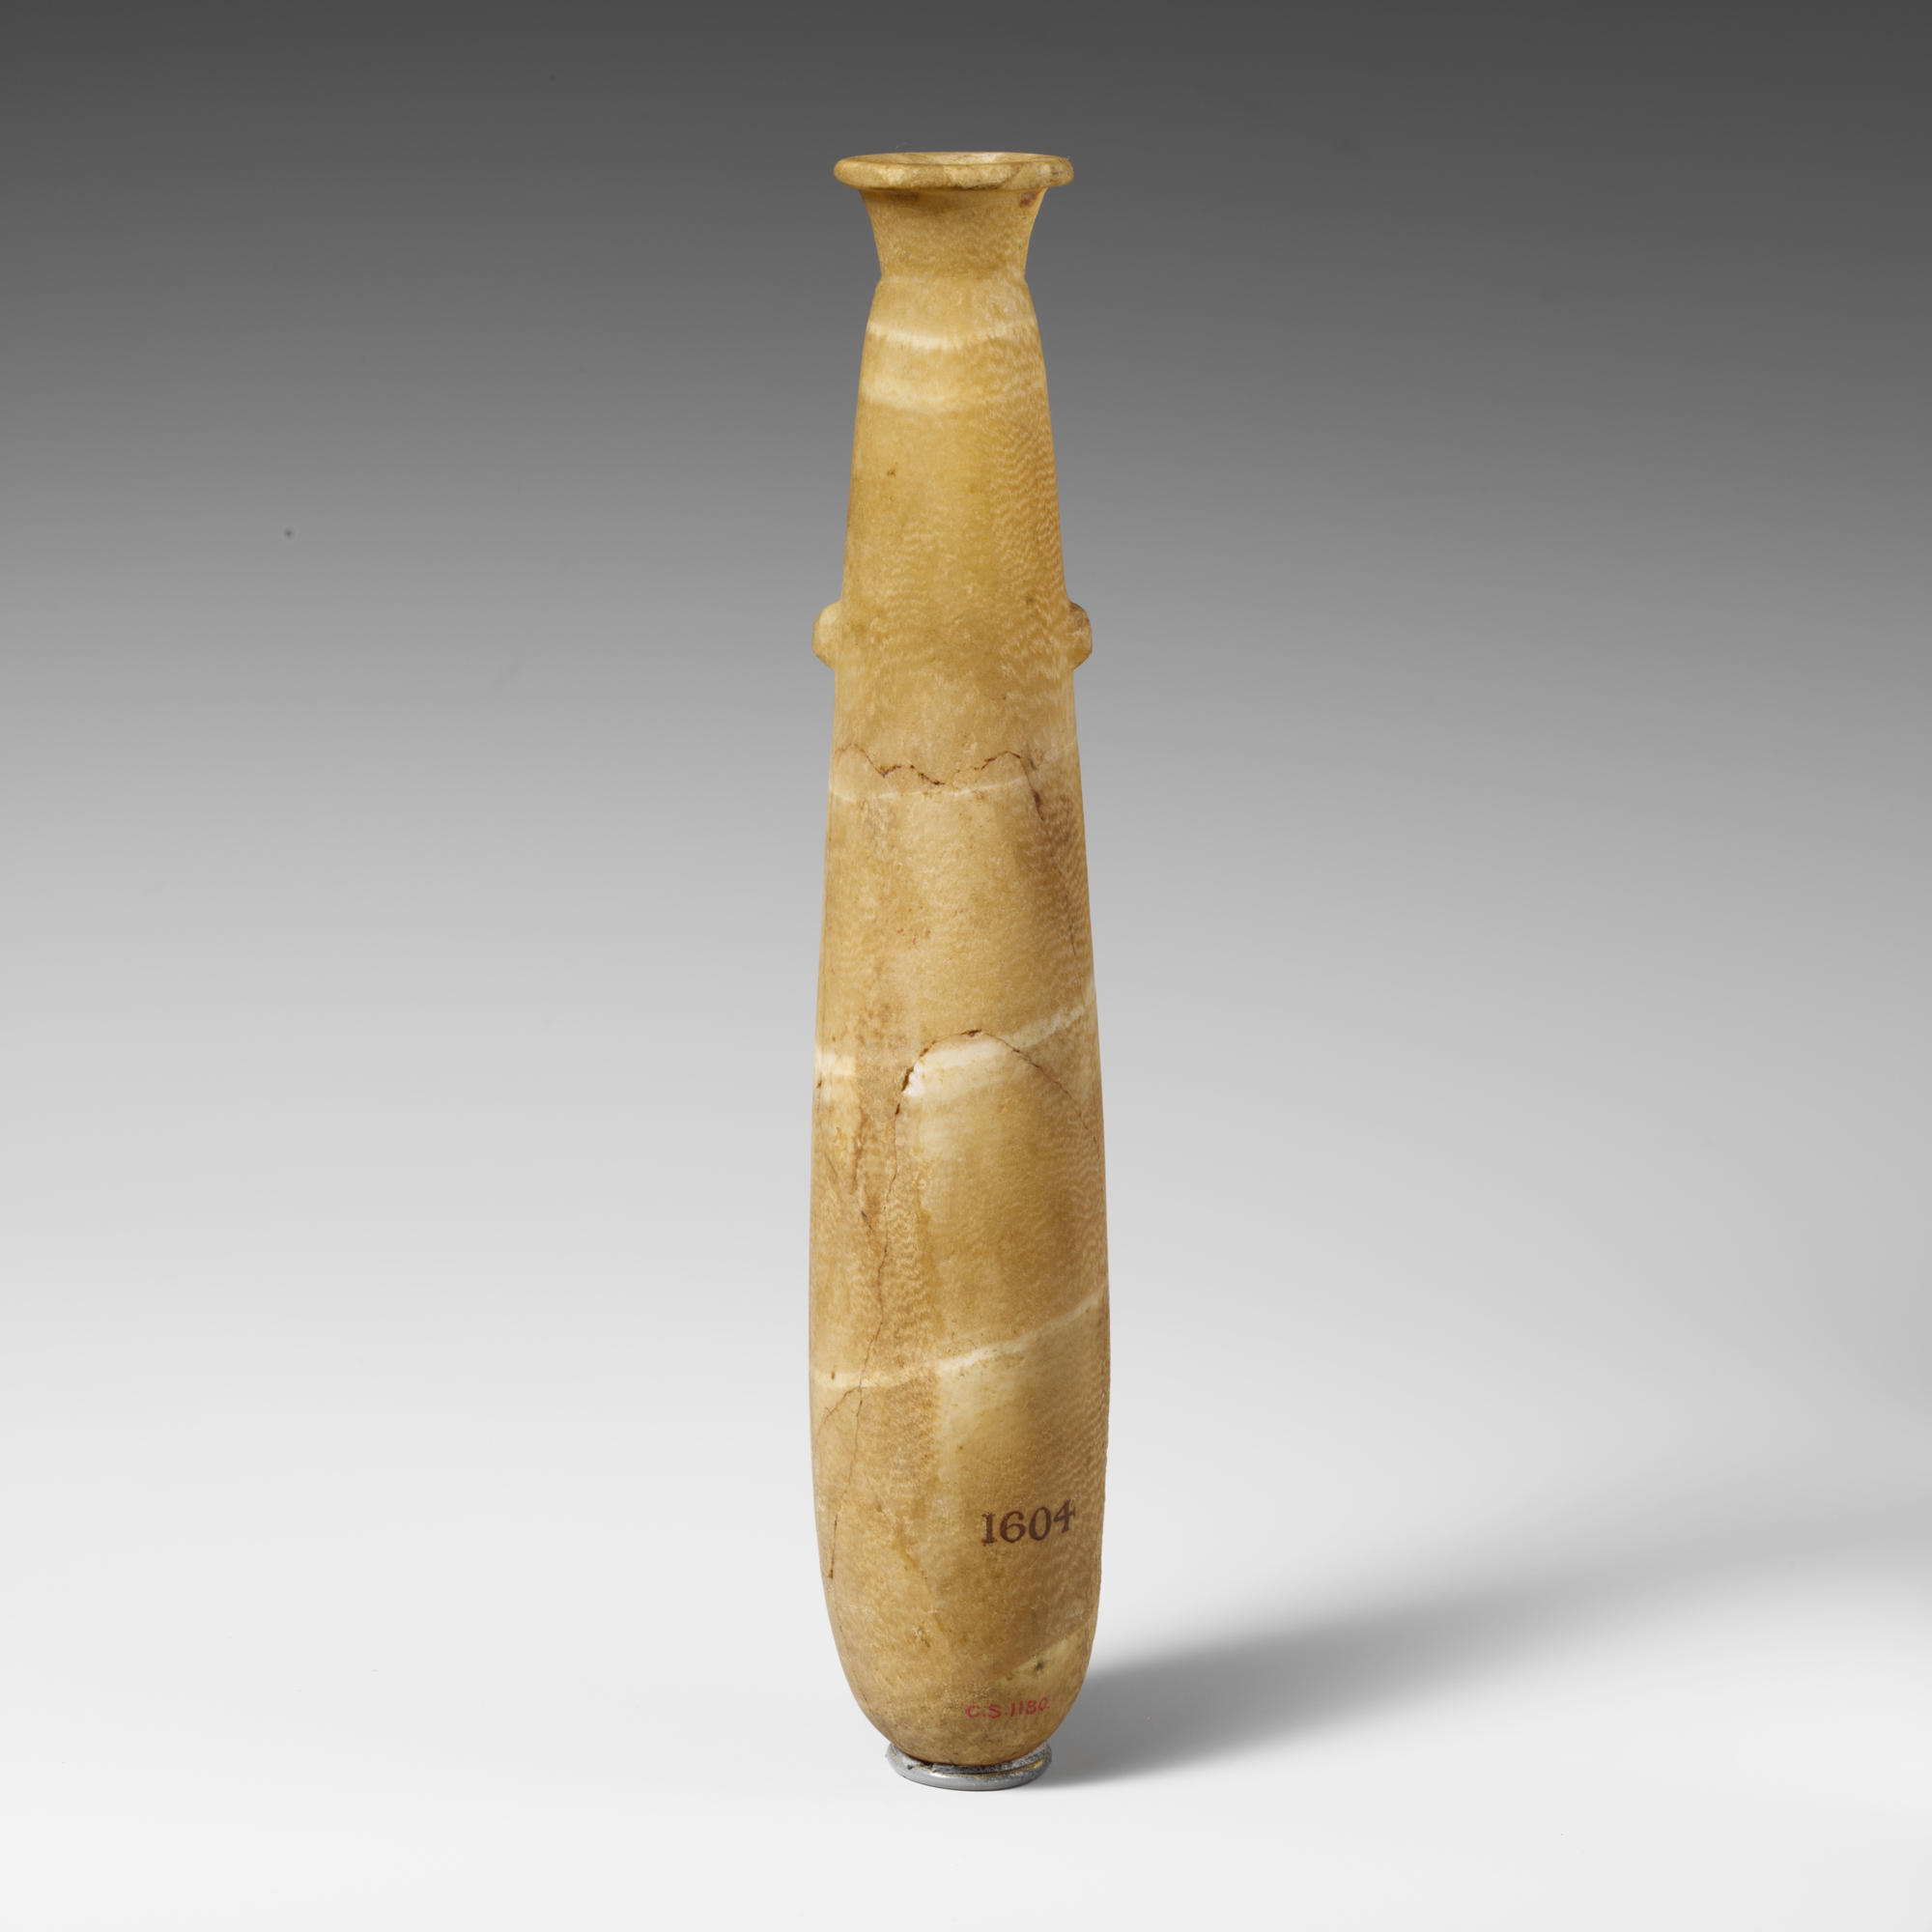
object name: alabastron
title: Alabaster alabastron (perfume vase)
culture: cypriot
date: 600-401 BCE